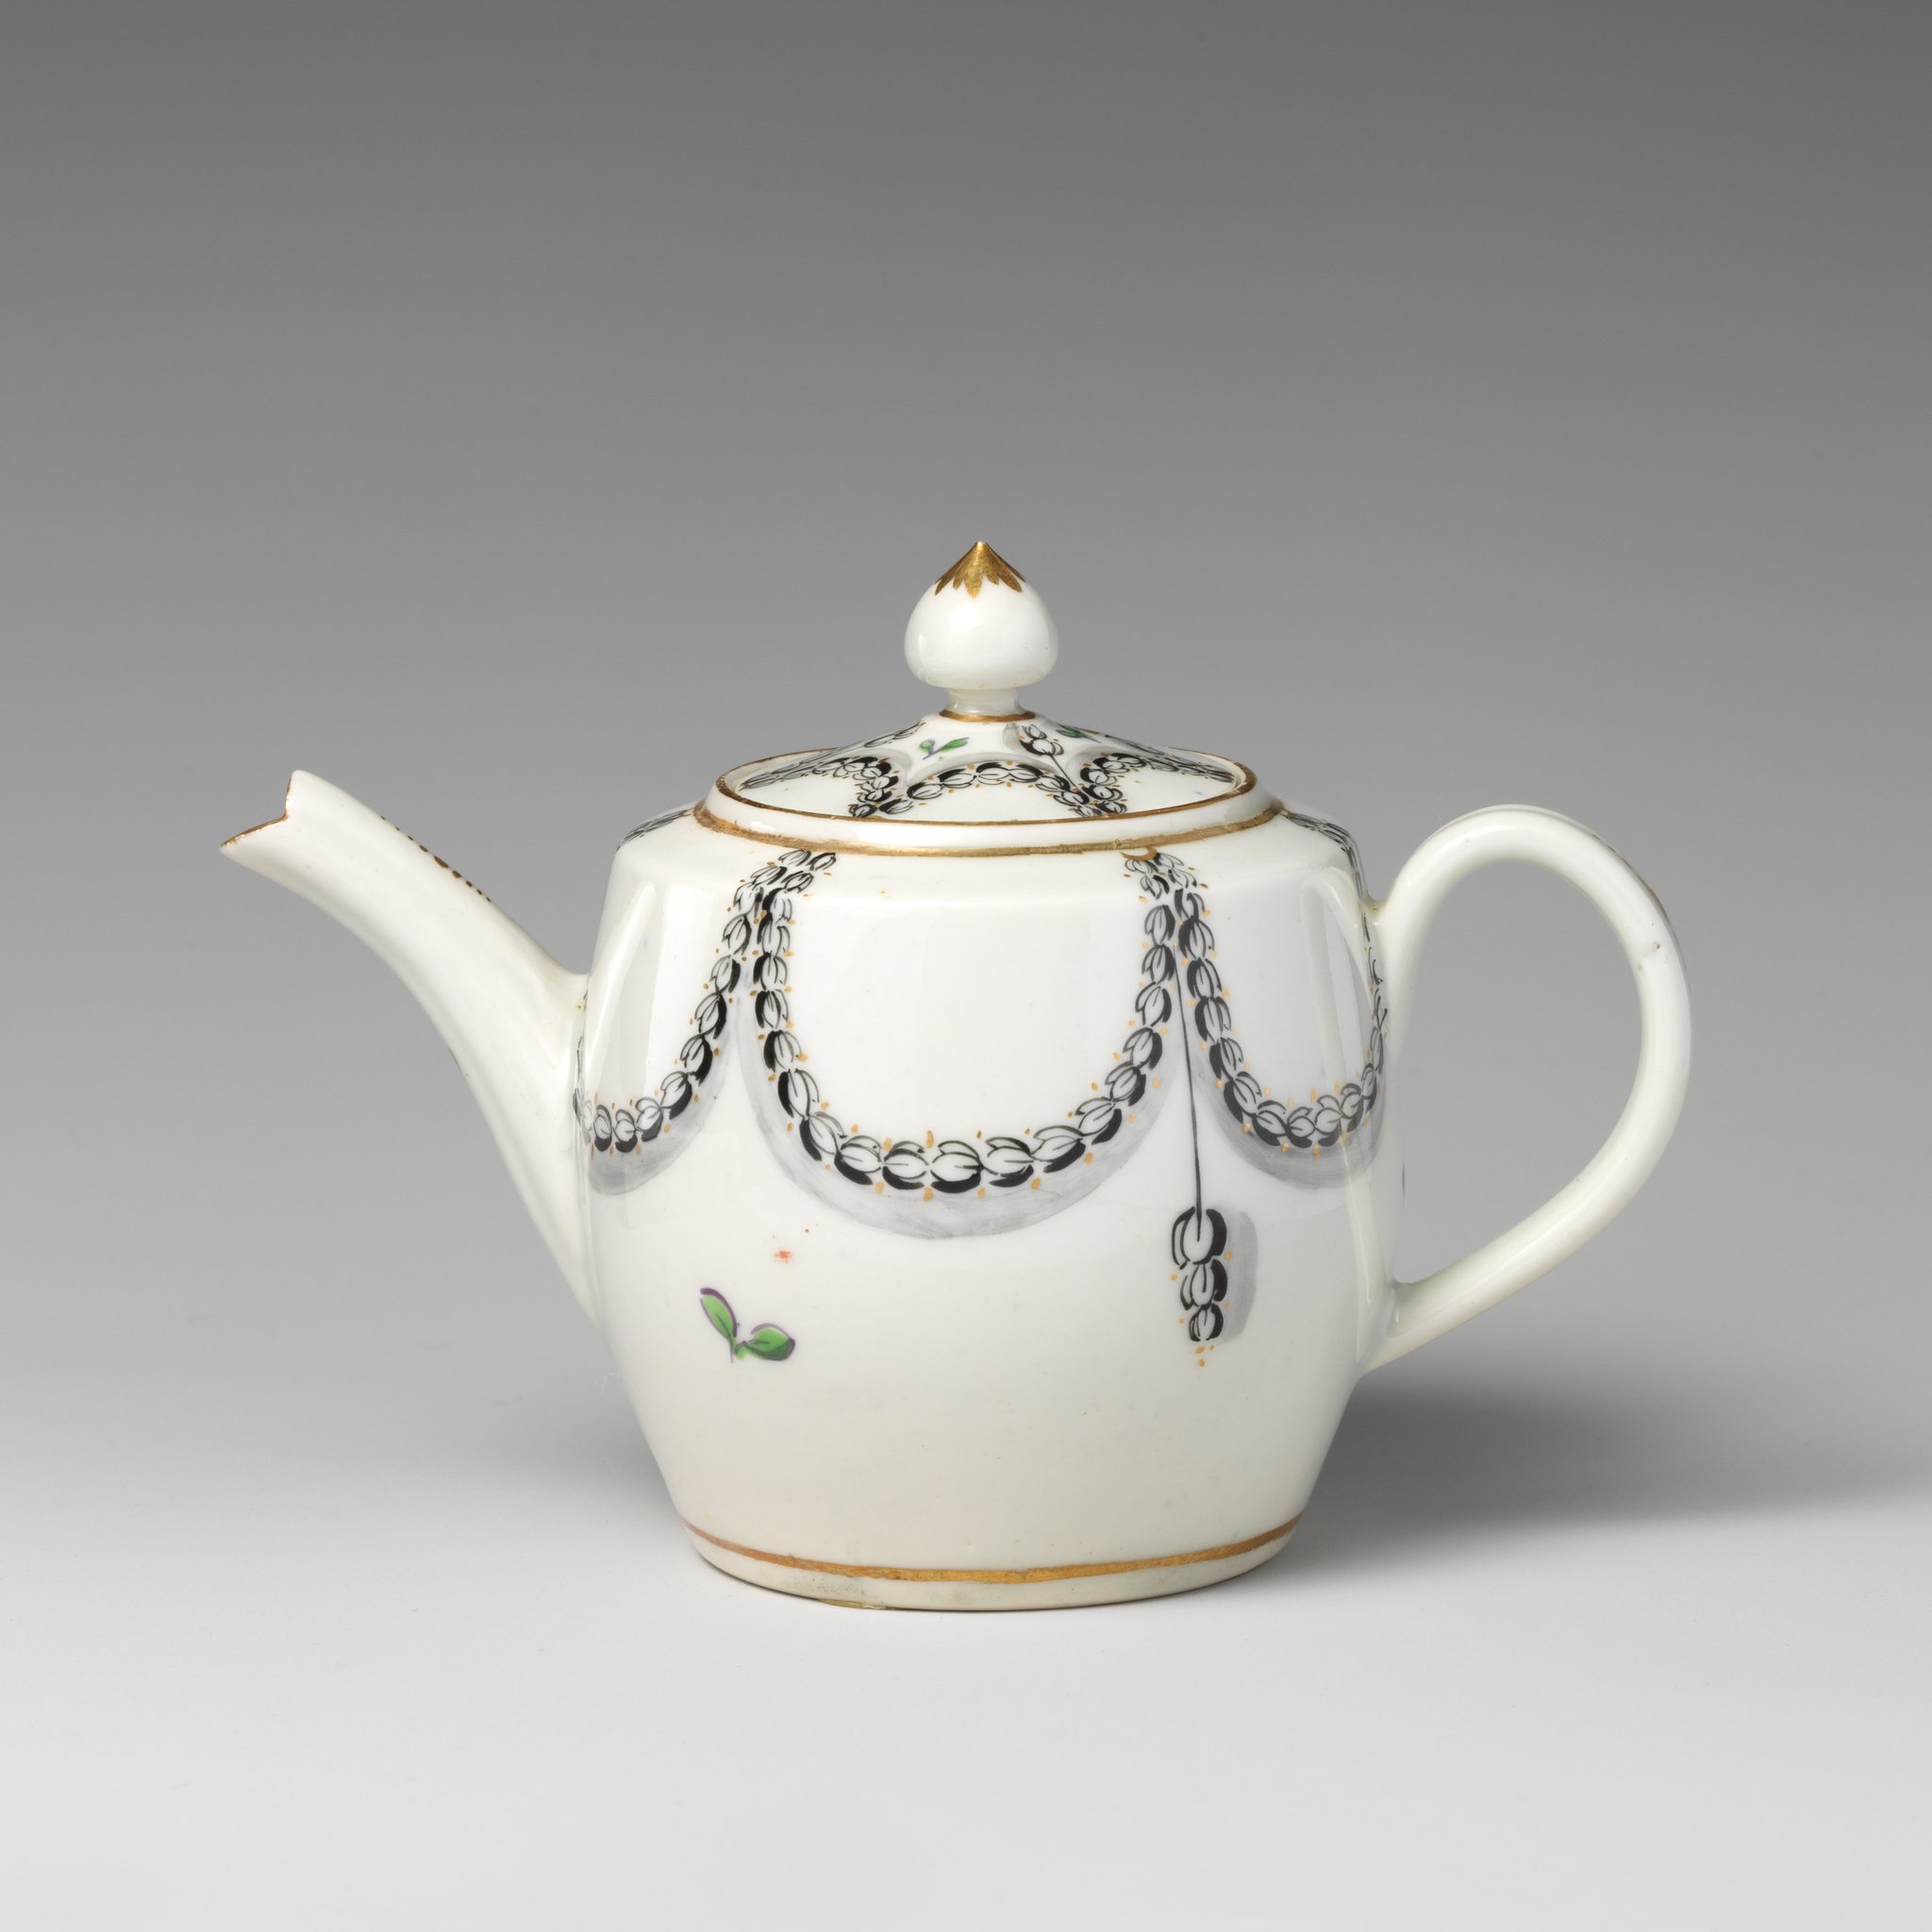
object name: teapot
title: Miniature teapot (part of a service)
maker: caughley factory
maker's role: factory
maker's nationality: british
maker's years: 1772-1799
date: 1780-1790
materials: enamel, soft paste porcelain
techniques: gilding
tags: flowers